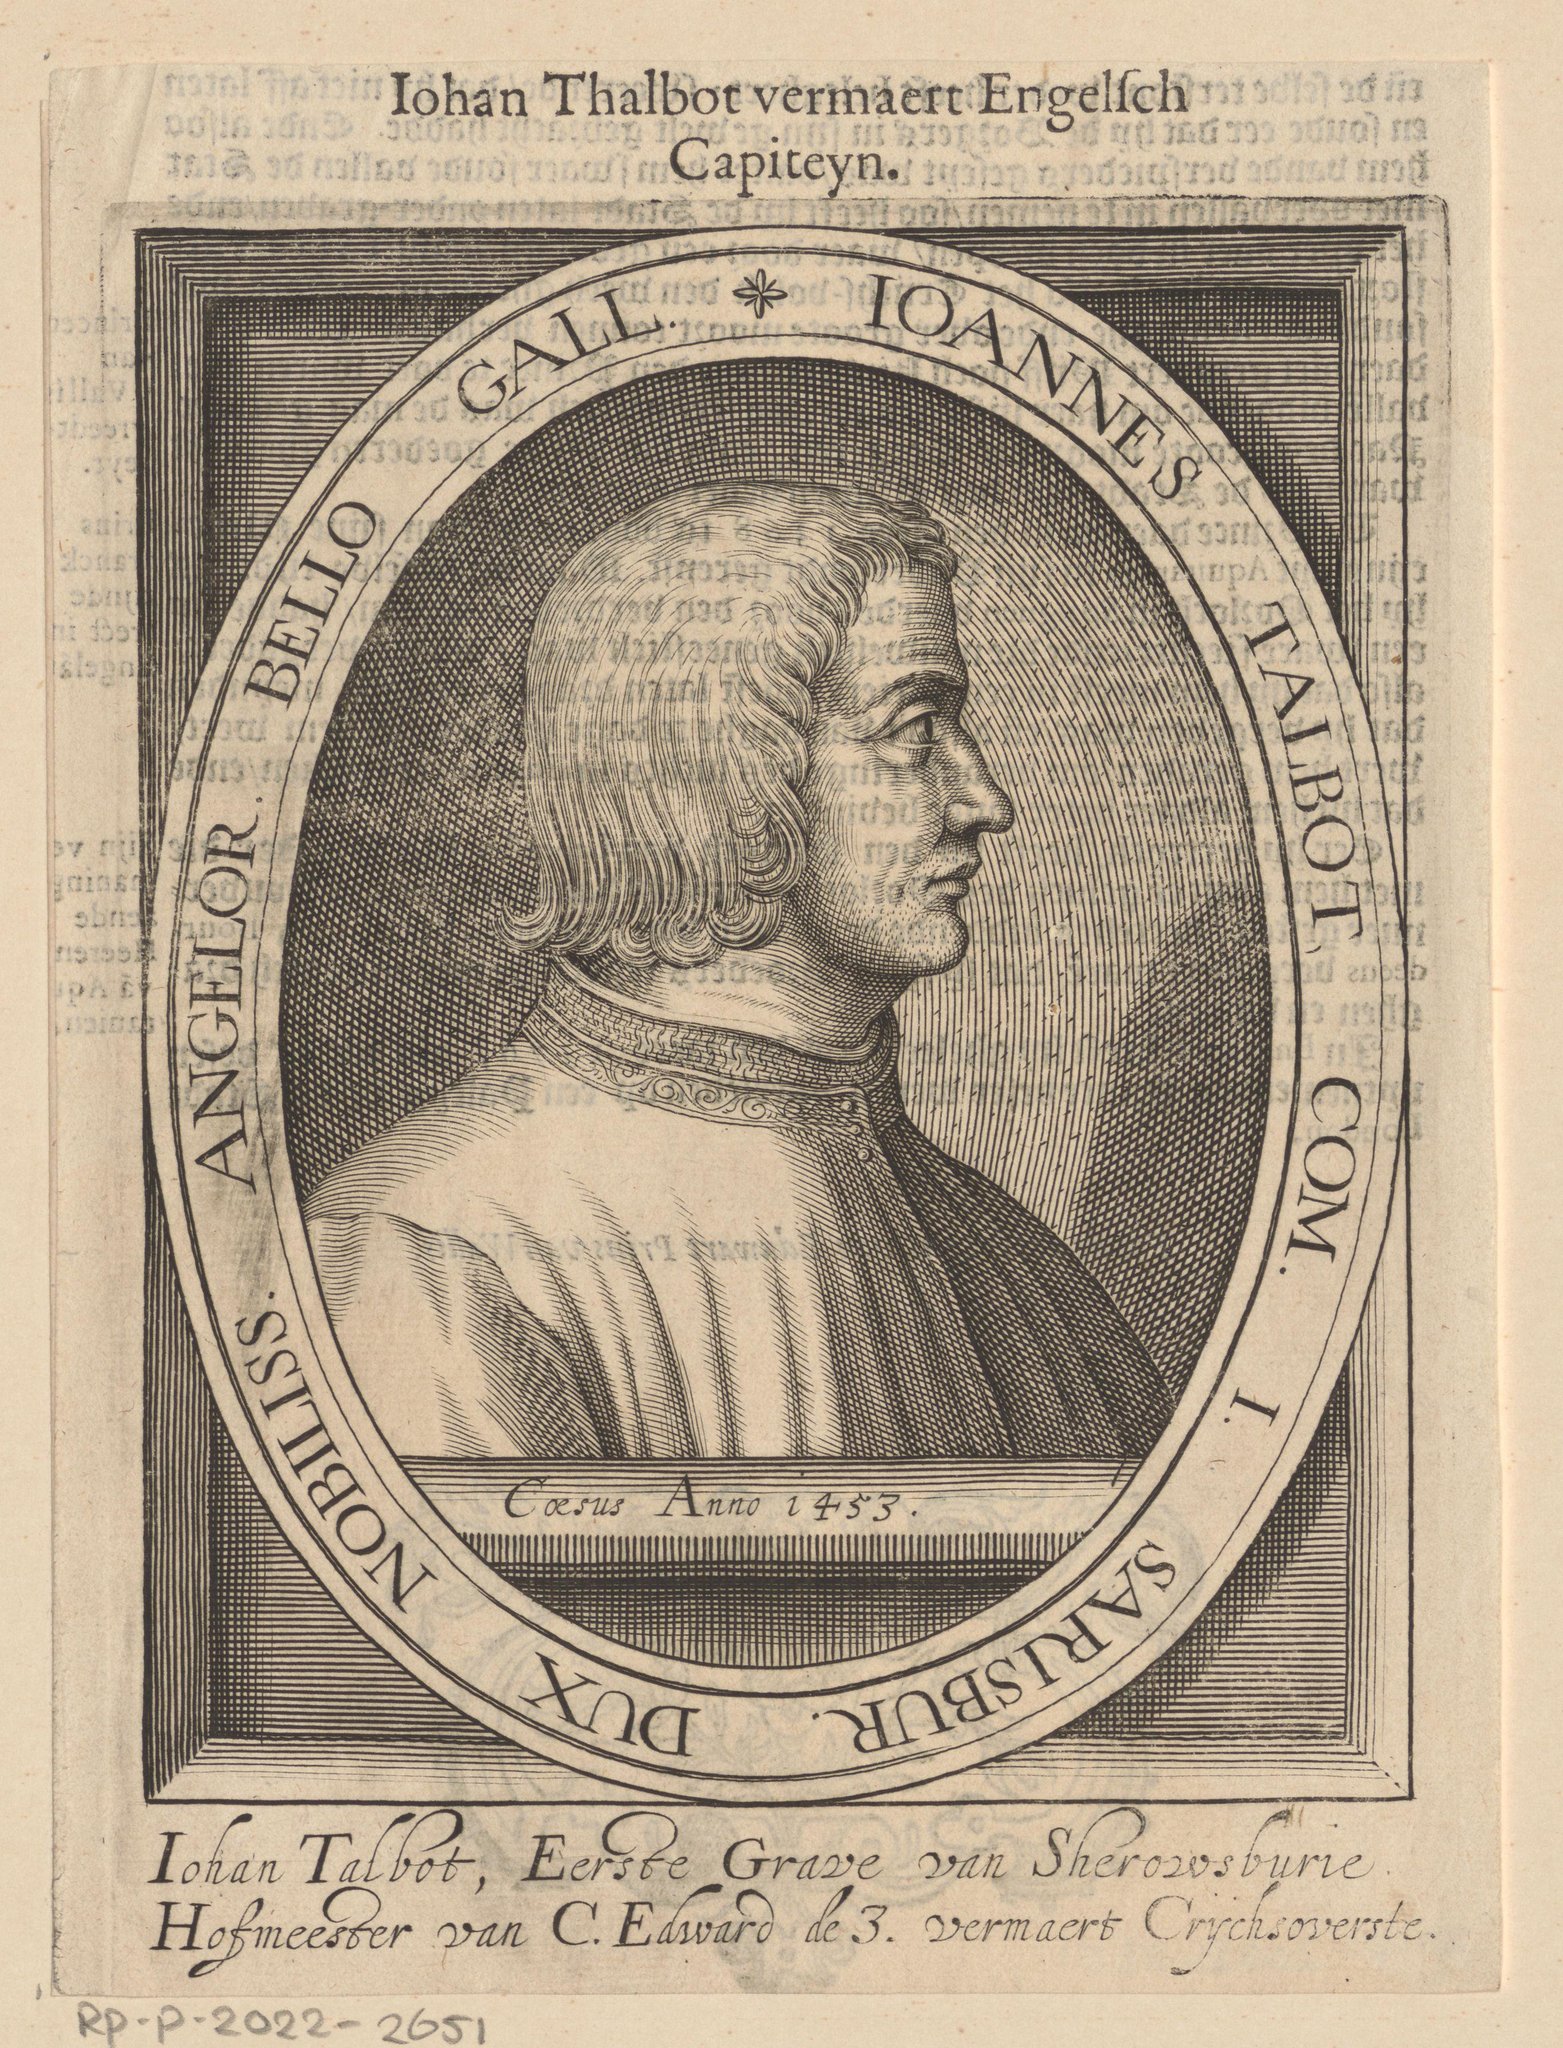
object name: print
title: Portret van John Talbot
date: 1617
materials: paper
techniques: engraving, letterpress printing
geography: delft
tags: commander-in-chief, general, marshal, historical persons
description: Prent uit: Tooneel der beroemder hertogen princen graven ende krygs-helden van christenrijck binnen deze drij laetste eeuwen. Delft: Nicolaes de Clerck, 1617.